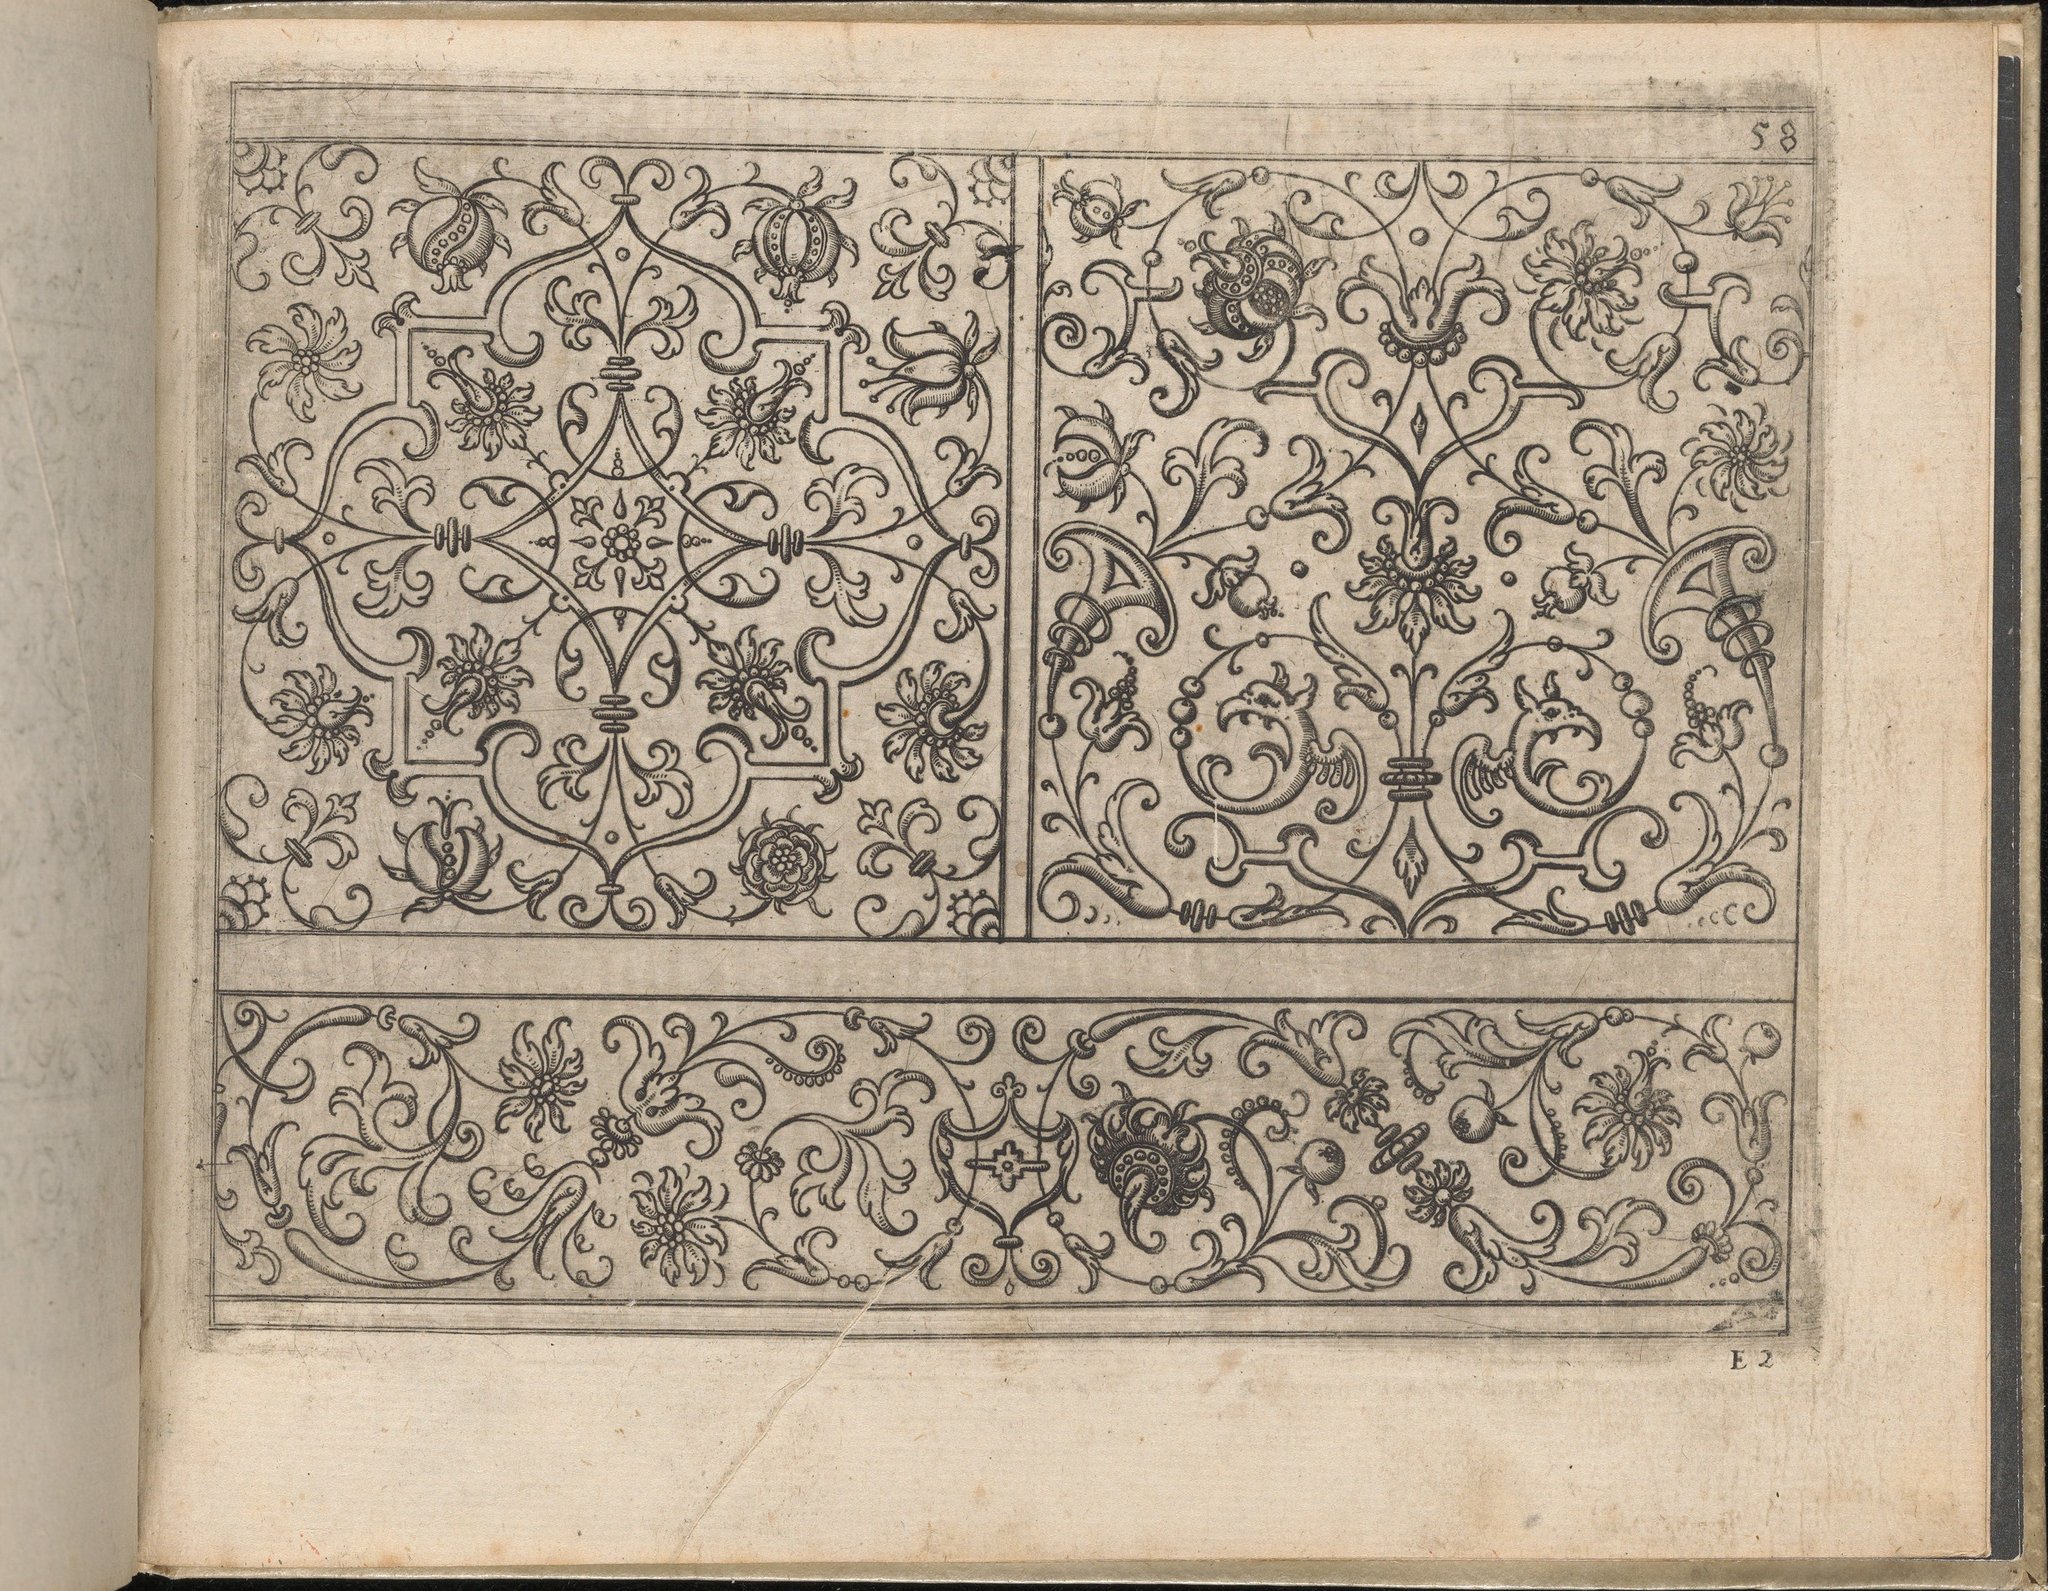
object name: book print ornament architecture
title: Newes Modelbuch in Kupffer (Page 66r)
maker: johann sibmacher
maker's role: artist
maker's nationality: german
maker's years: 1590-1611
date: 1604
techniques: etching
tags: fruit,flowers